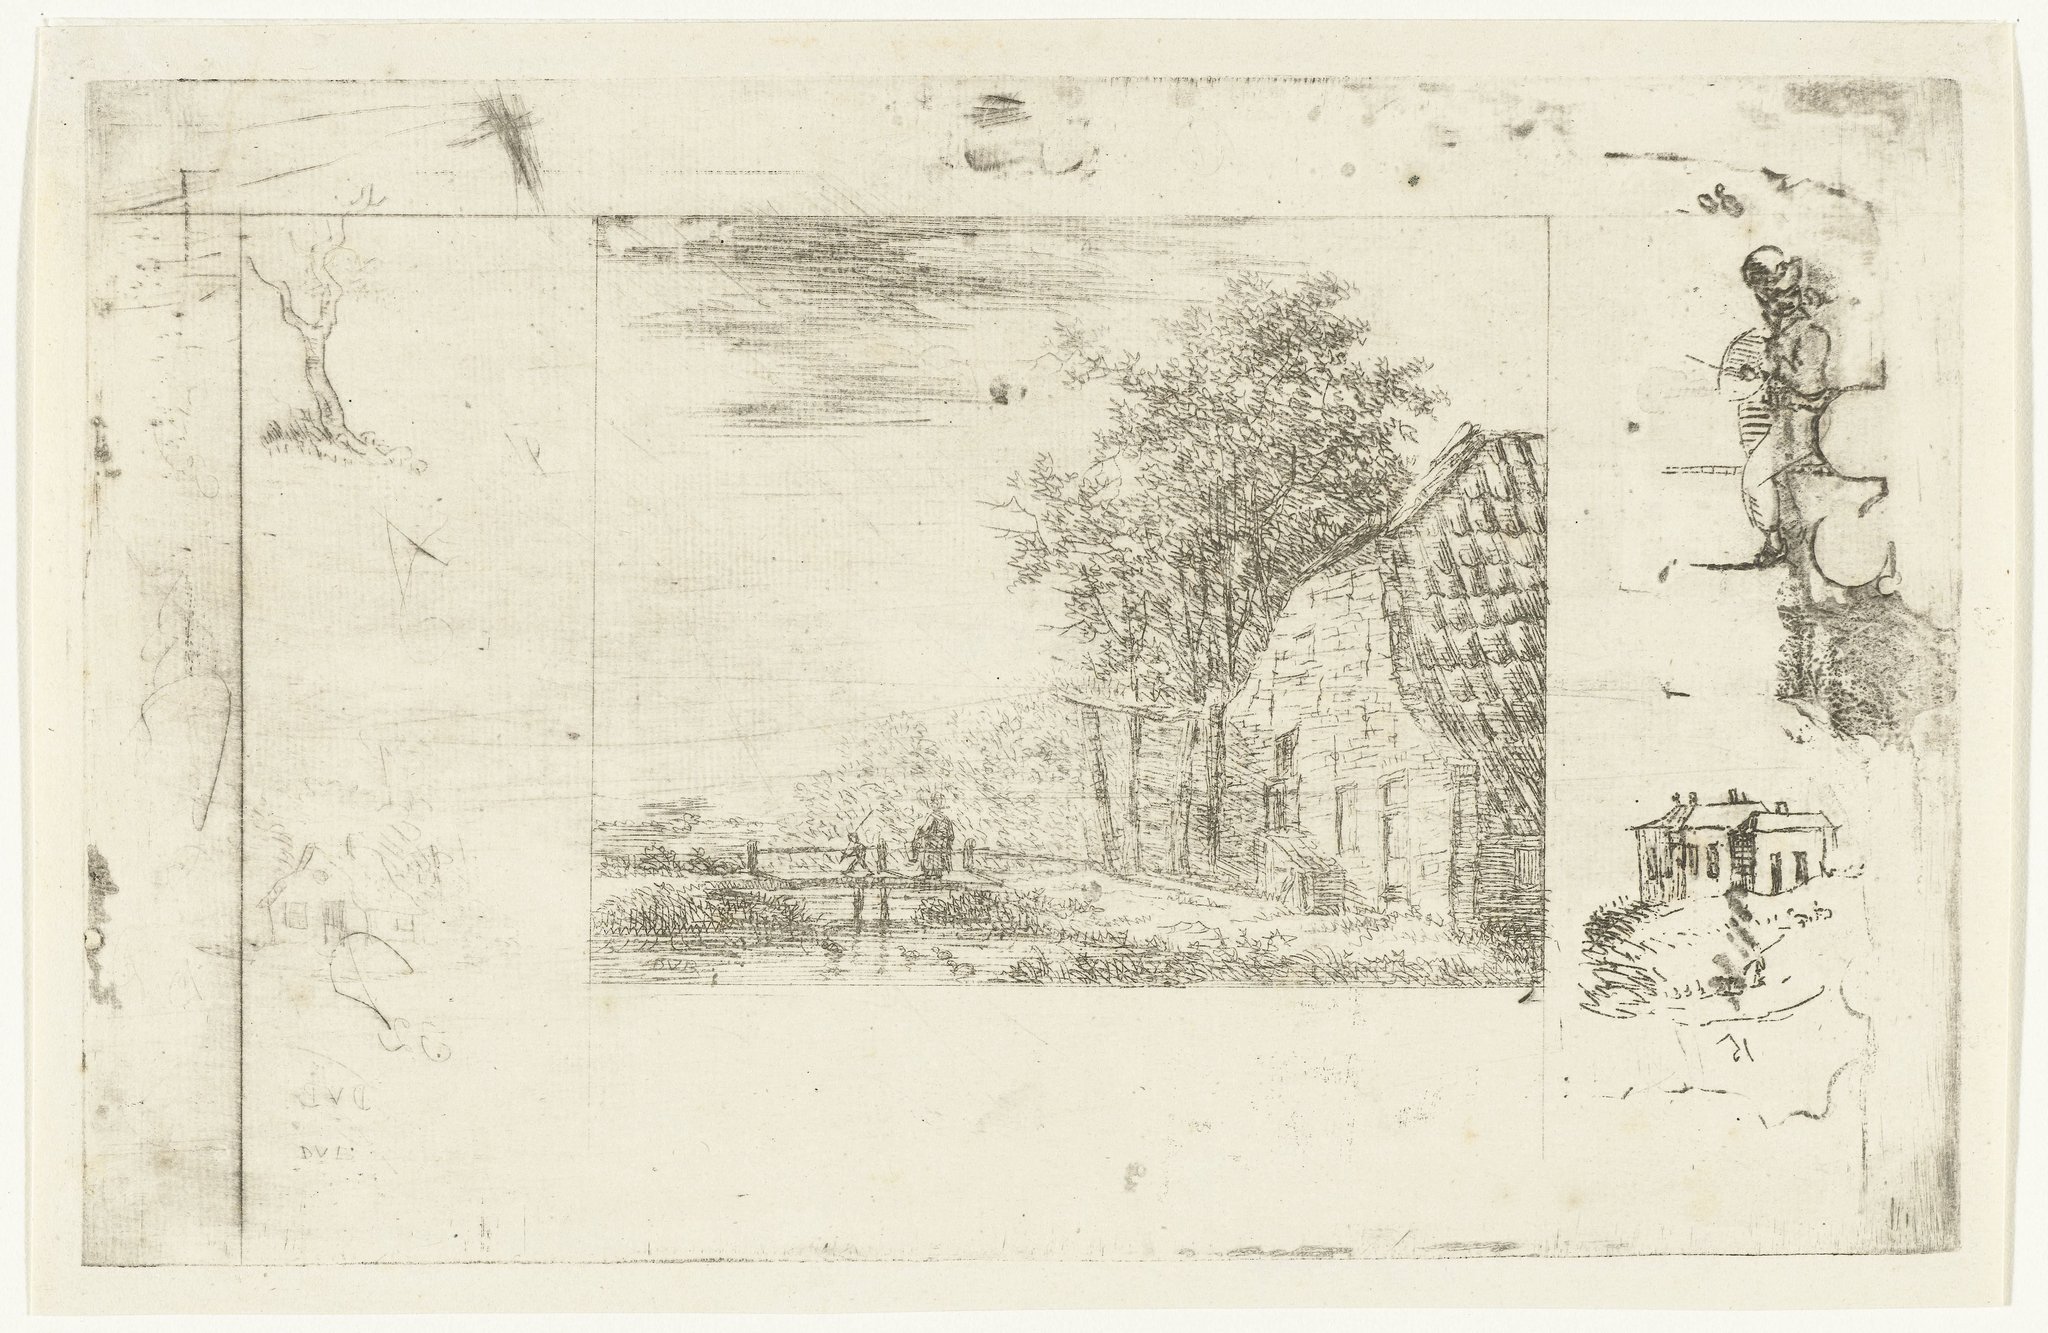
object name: print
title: Landschap met boerderij bij sloot met bruggetje en schetsjes in marge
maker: dirk vis blokhuyzen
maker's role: print maker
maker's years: 1799-1869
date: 1809-1869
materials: paper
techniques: etching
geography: rotterdam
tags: farm or solitary house in landscape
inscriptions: collector's mark: Lugt 2228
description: Landschap met boerderij bij sloot met bruggetje. In de marge staan kleine schetsjes van een schilder met zijn palet, gebouwen in een landschap en een boom.